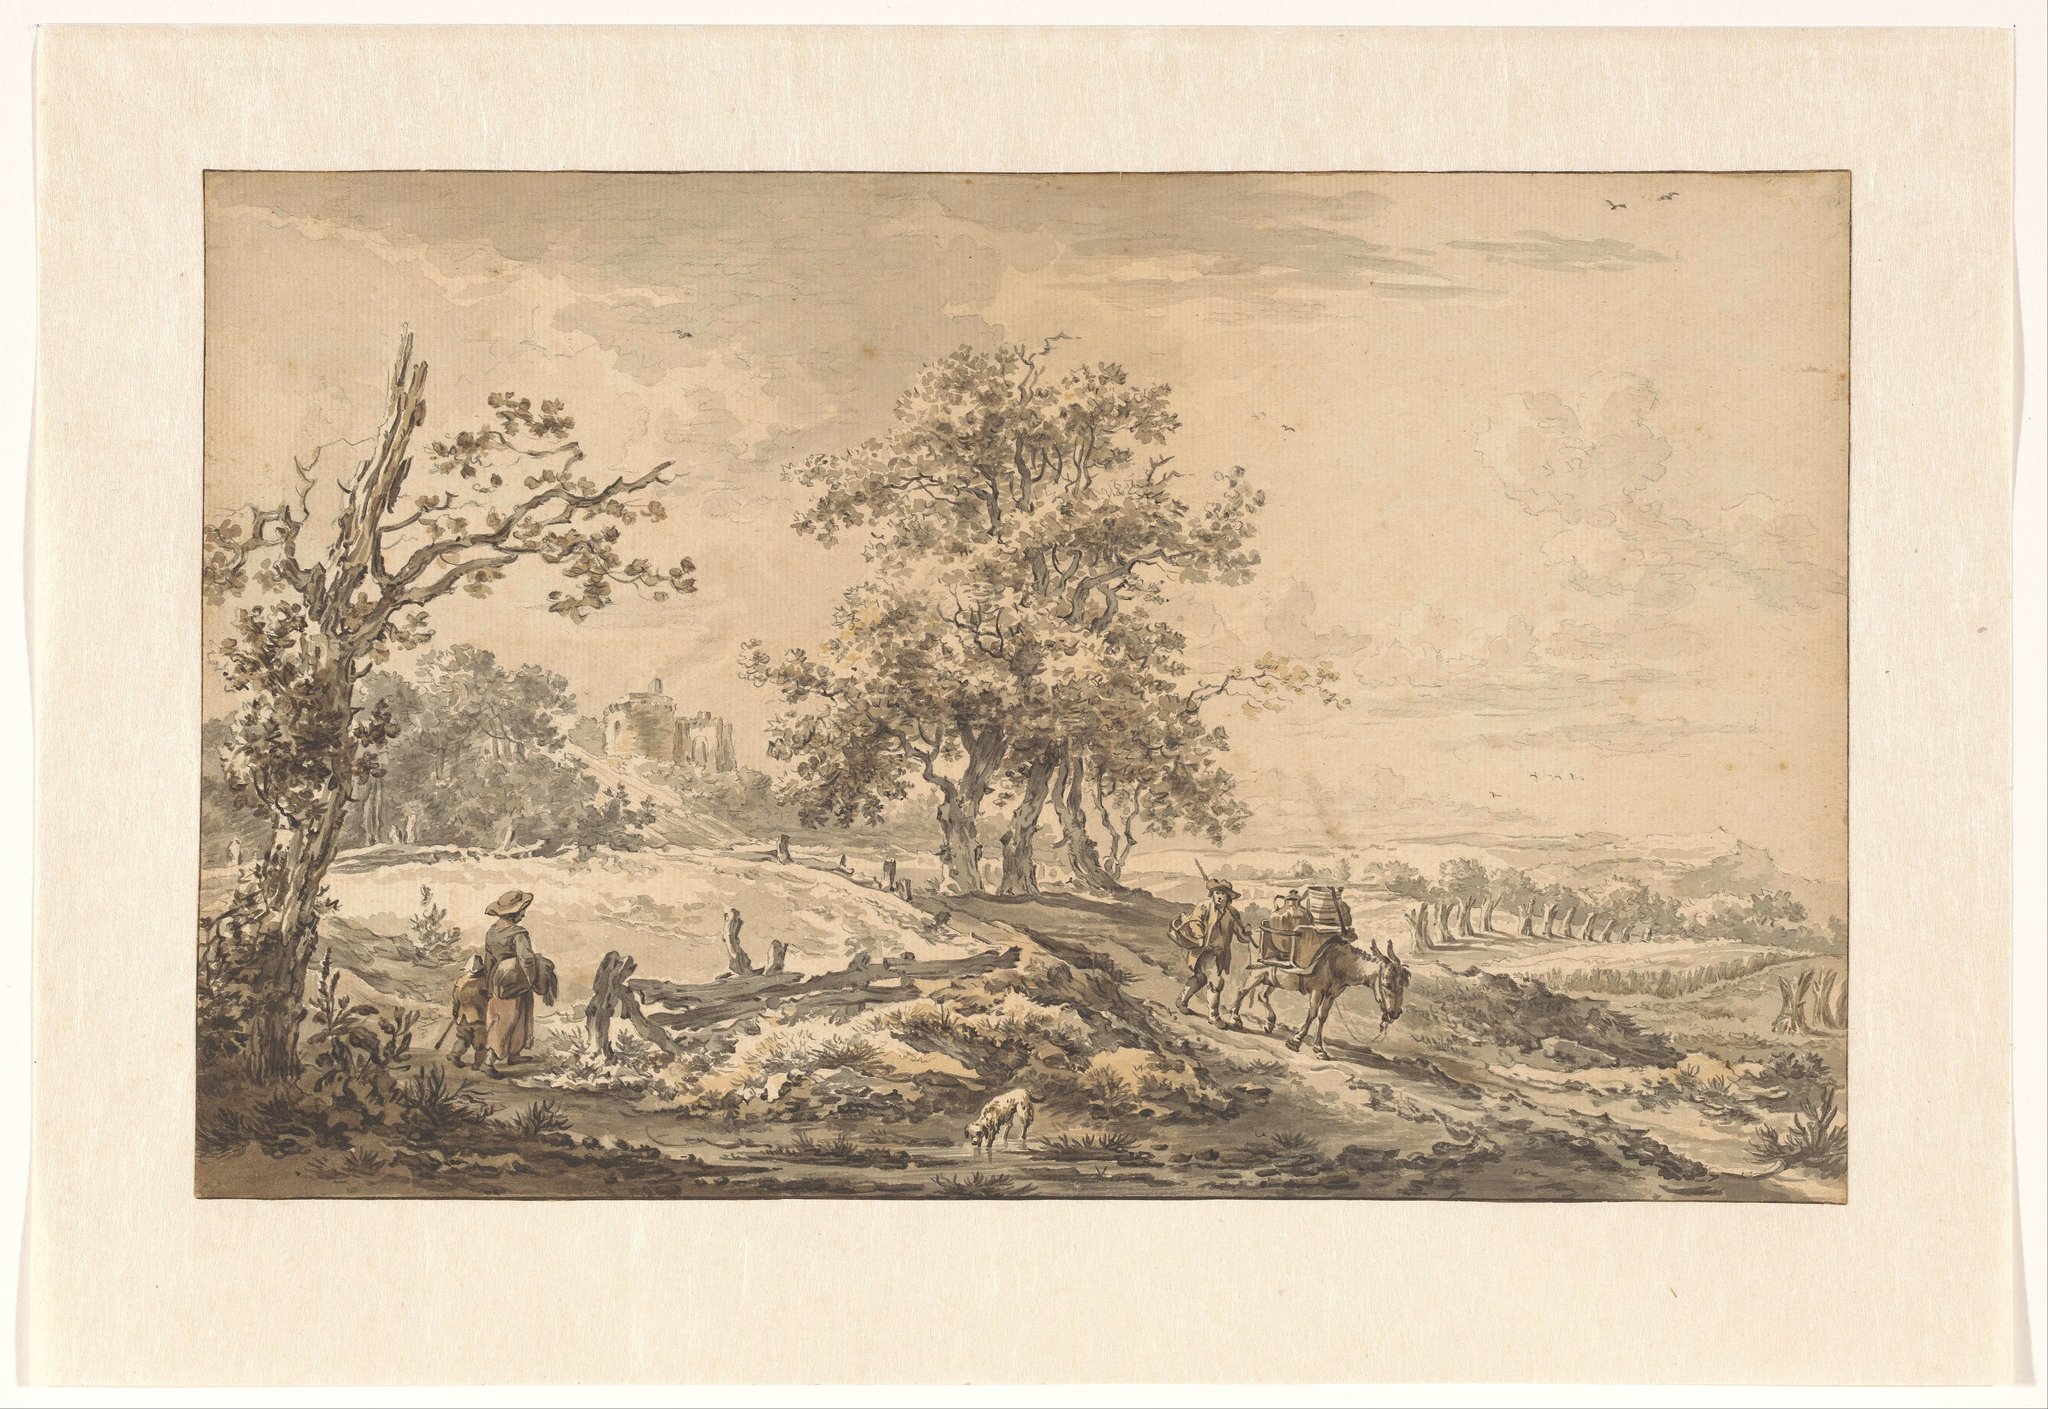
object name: watercolor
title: Vrouw met kind en man met ezel in landschap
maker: egbert van drielst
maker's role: draughtsman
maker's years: 1745-1818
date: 1755-1818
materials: paper, pencil, pigment, watercolor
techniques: brush, pen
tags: low hill country, landscape with ruins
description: Links een vrouw met kind op een landweg. In het midden drinkt een hond uit een regenplas. Rechts loopt een man met muilezel. Achter drie eiken de omtrekken van een ruïne van een burcht.